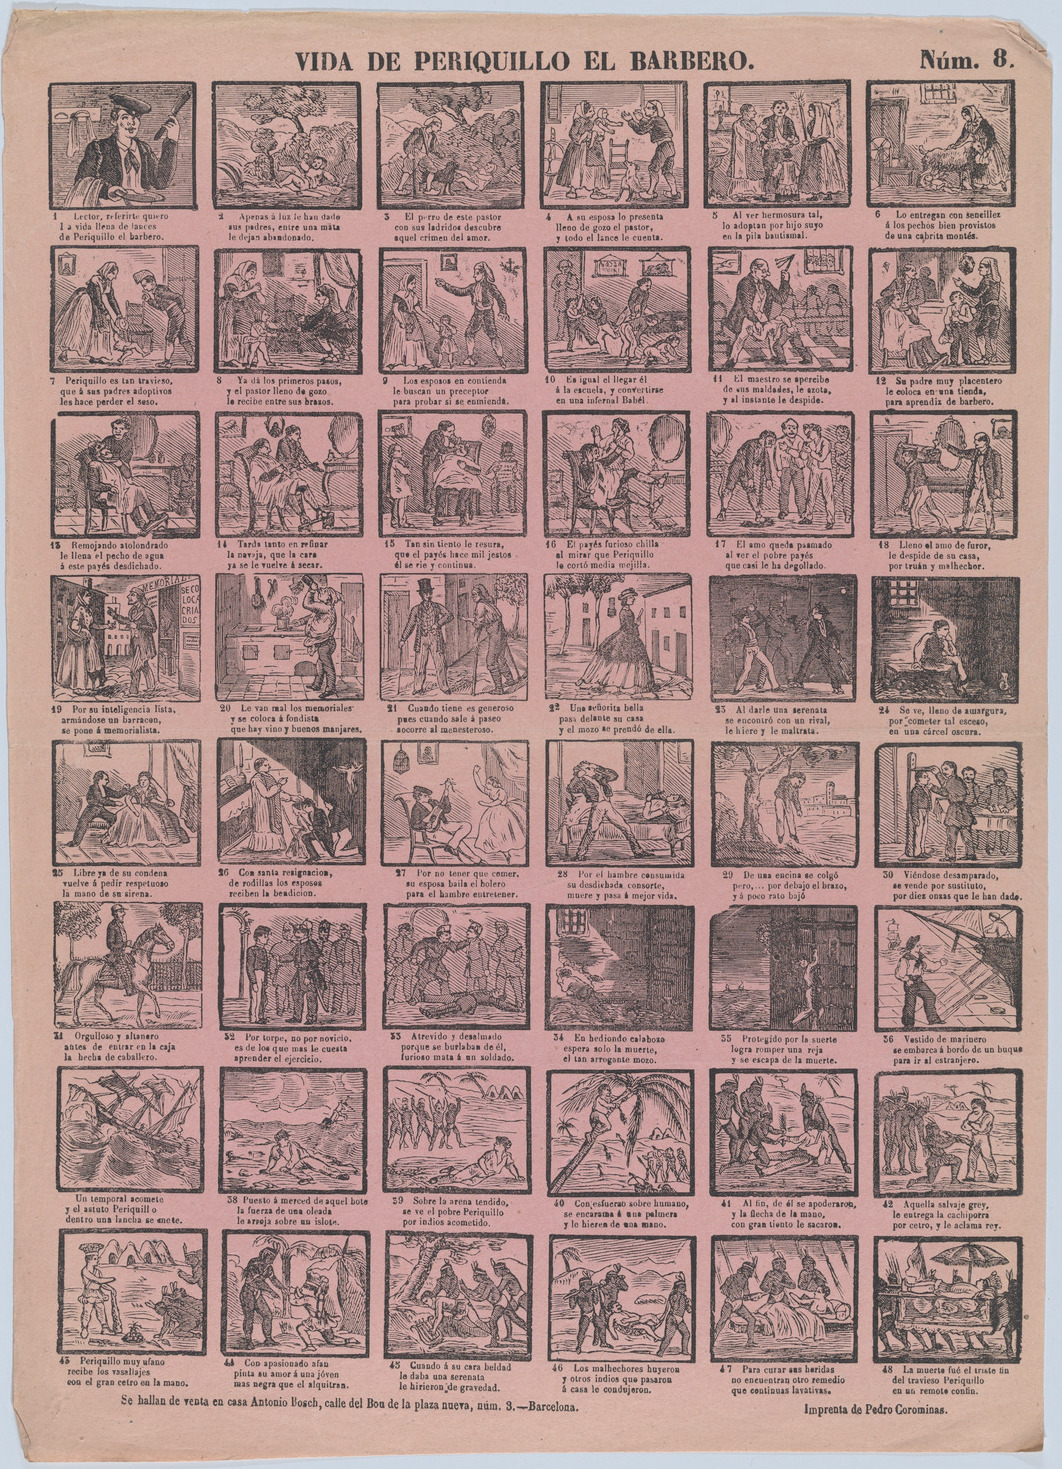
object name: print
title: Broadside with 48 scenes from the life of Periquillo the Barber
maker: antonio bosch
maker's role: publisher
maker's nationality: spanish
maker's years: 1860-1880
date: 1860-1870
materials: paper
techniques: printing, engraving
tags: animals,infants,men,women